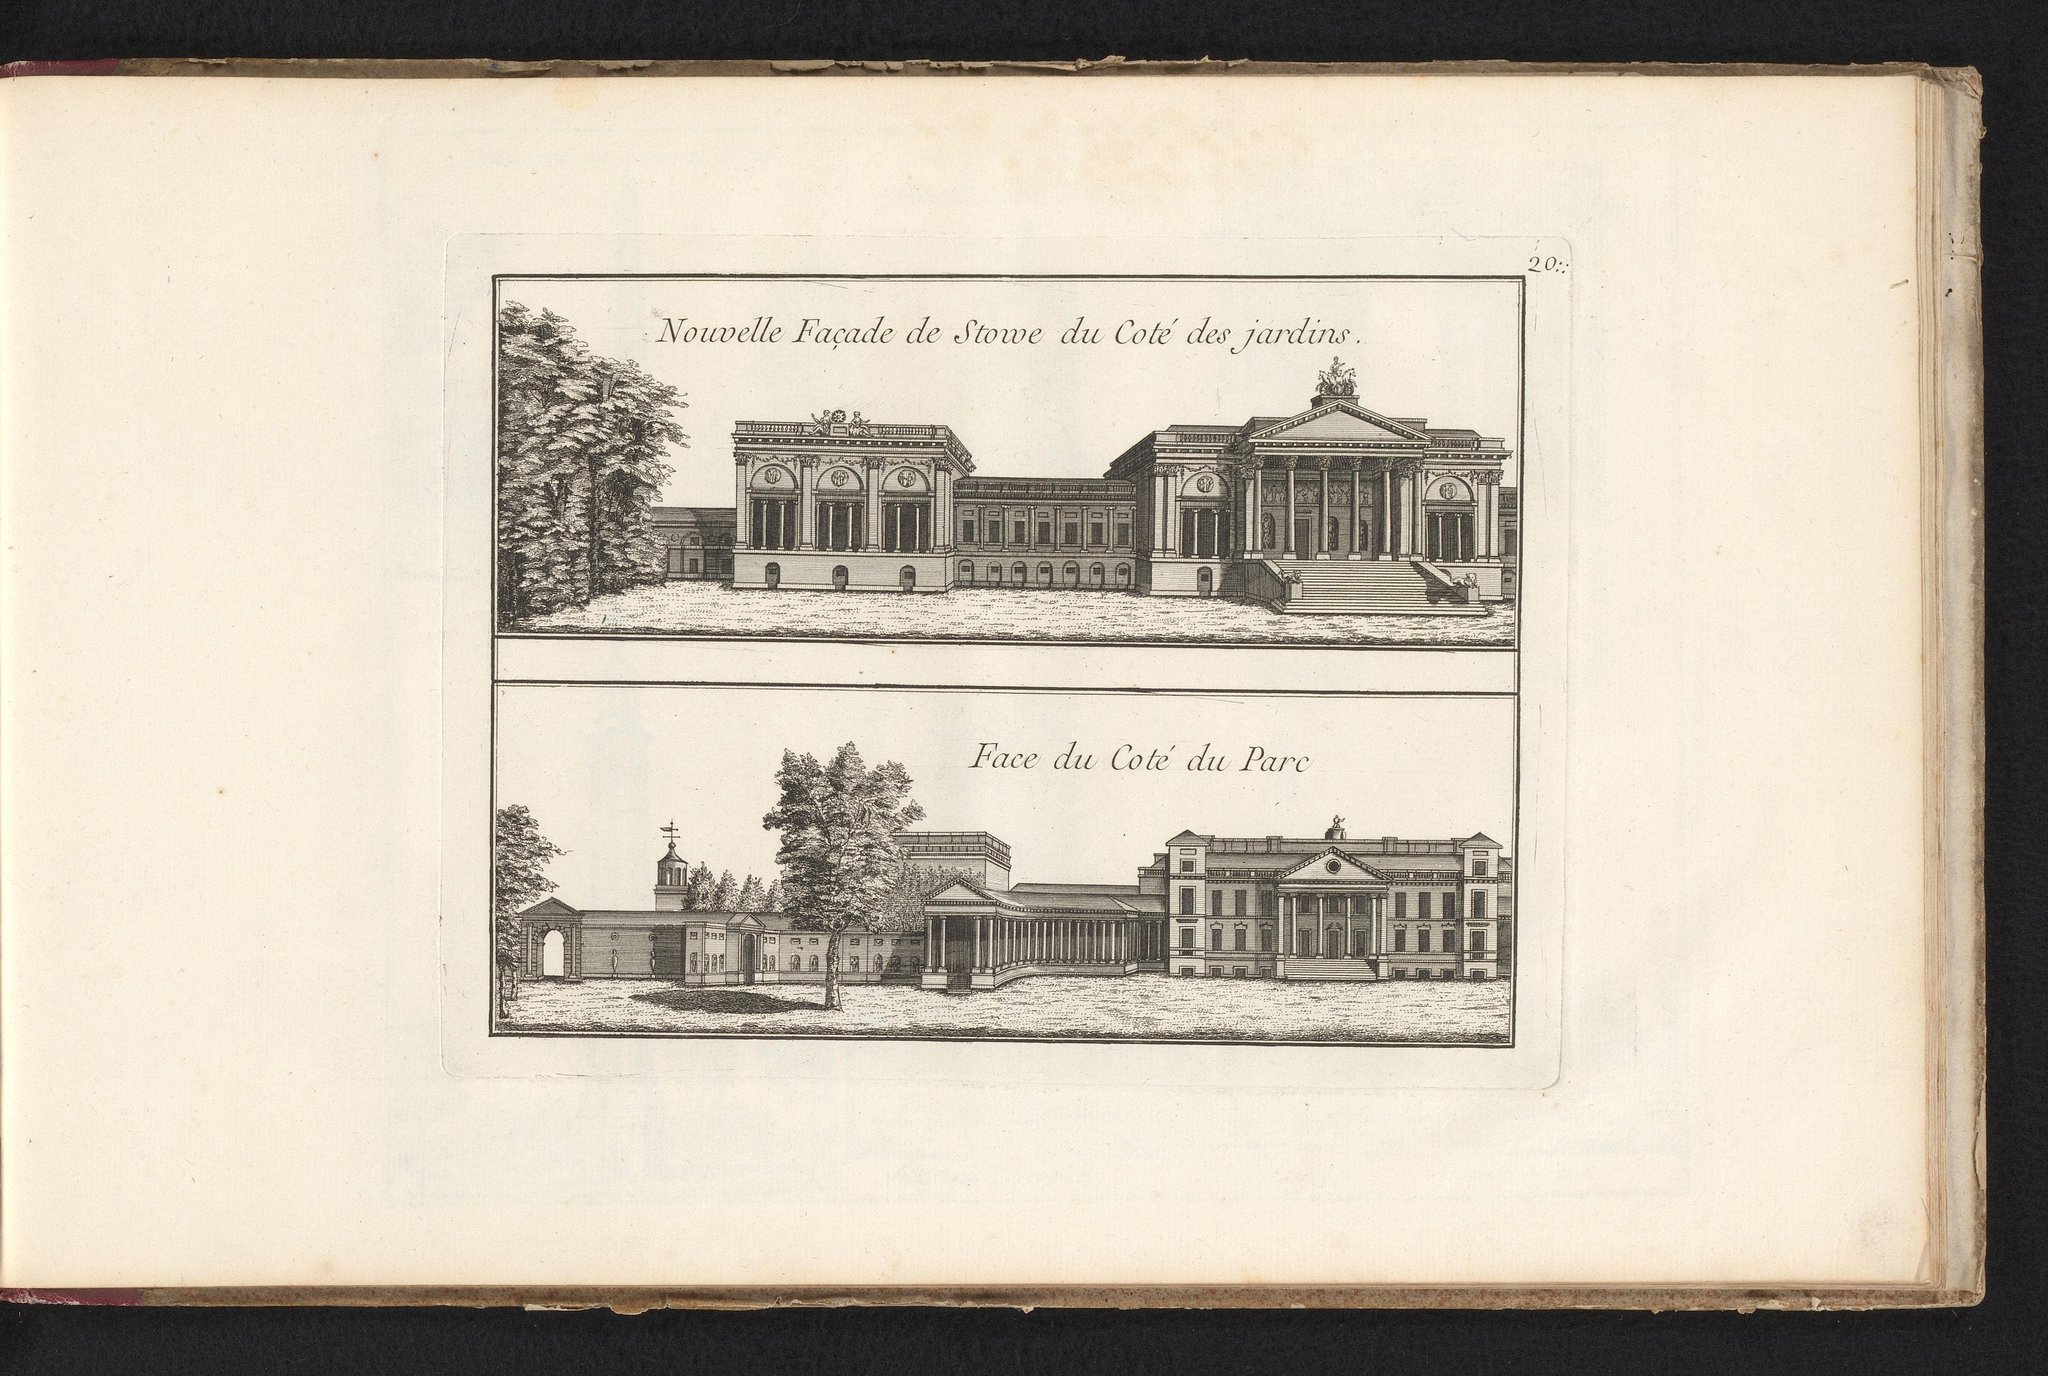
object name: print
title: Jardins anglo-chinois à la mode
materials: paper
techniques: engraving, etching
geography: paris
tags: castle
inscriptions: collector's mark: Lugt 2228, collector's mark: Lugt 2760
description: De serie 'Jardins anglo-chinois à la mode' verscheen in totaal in 21 zogeheten 'cahiers' (afleveringen). De huidige prent komt uit het vierde 'cahier'. Het Rijksmuseum Amsterdam bezit drie banden met daarin in totaal zes 'cahiers' van deze reeks. In de documentatie wordt verwezen naar een in de bibliotheek van het Rijksmuseum Amsterdam aanwezige facsimile van het complete werk.